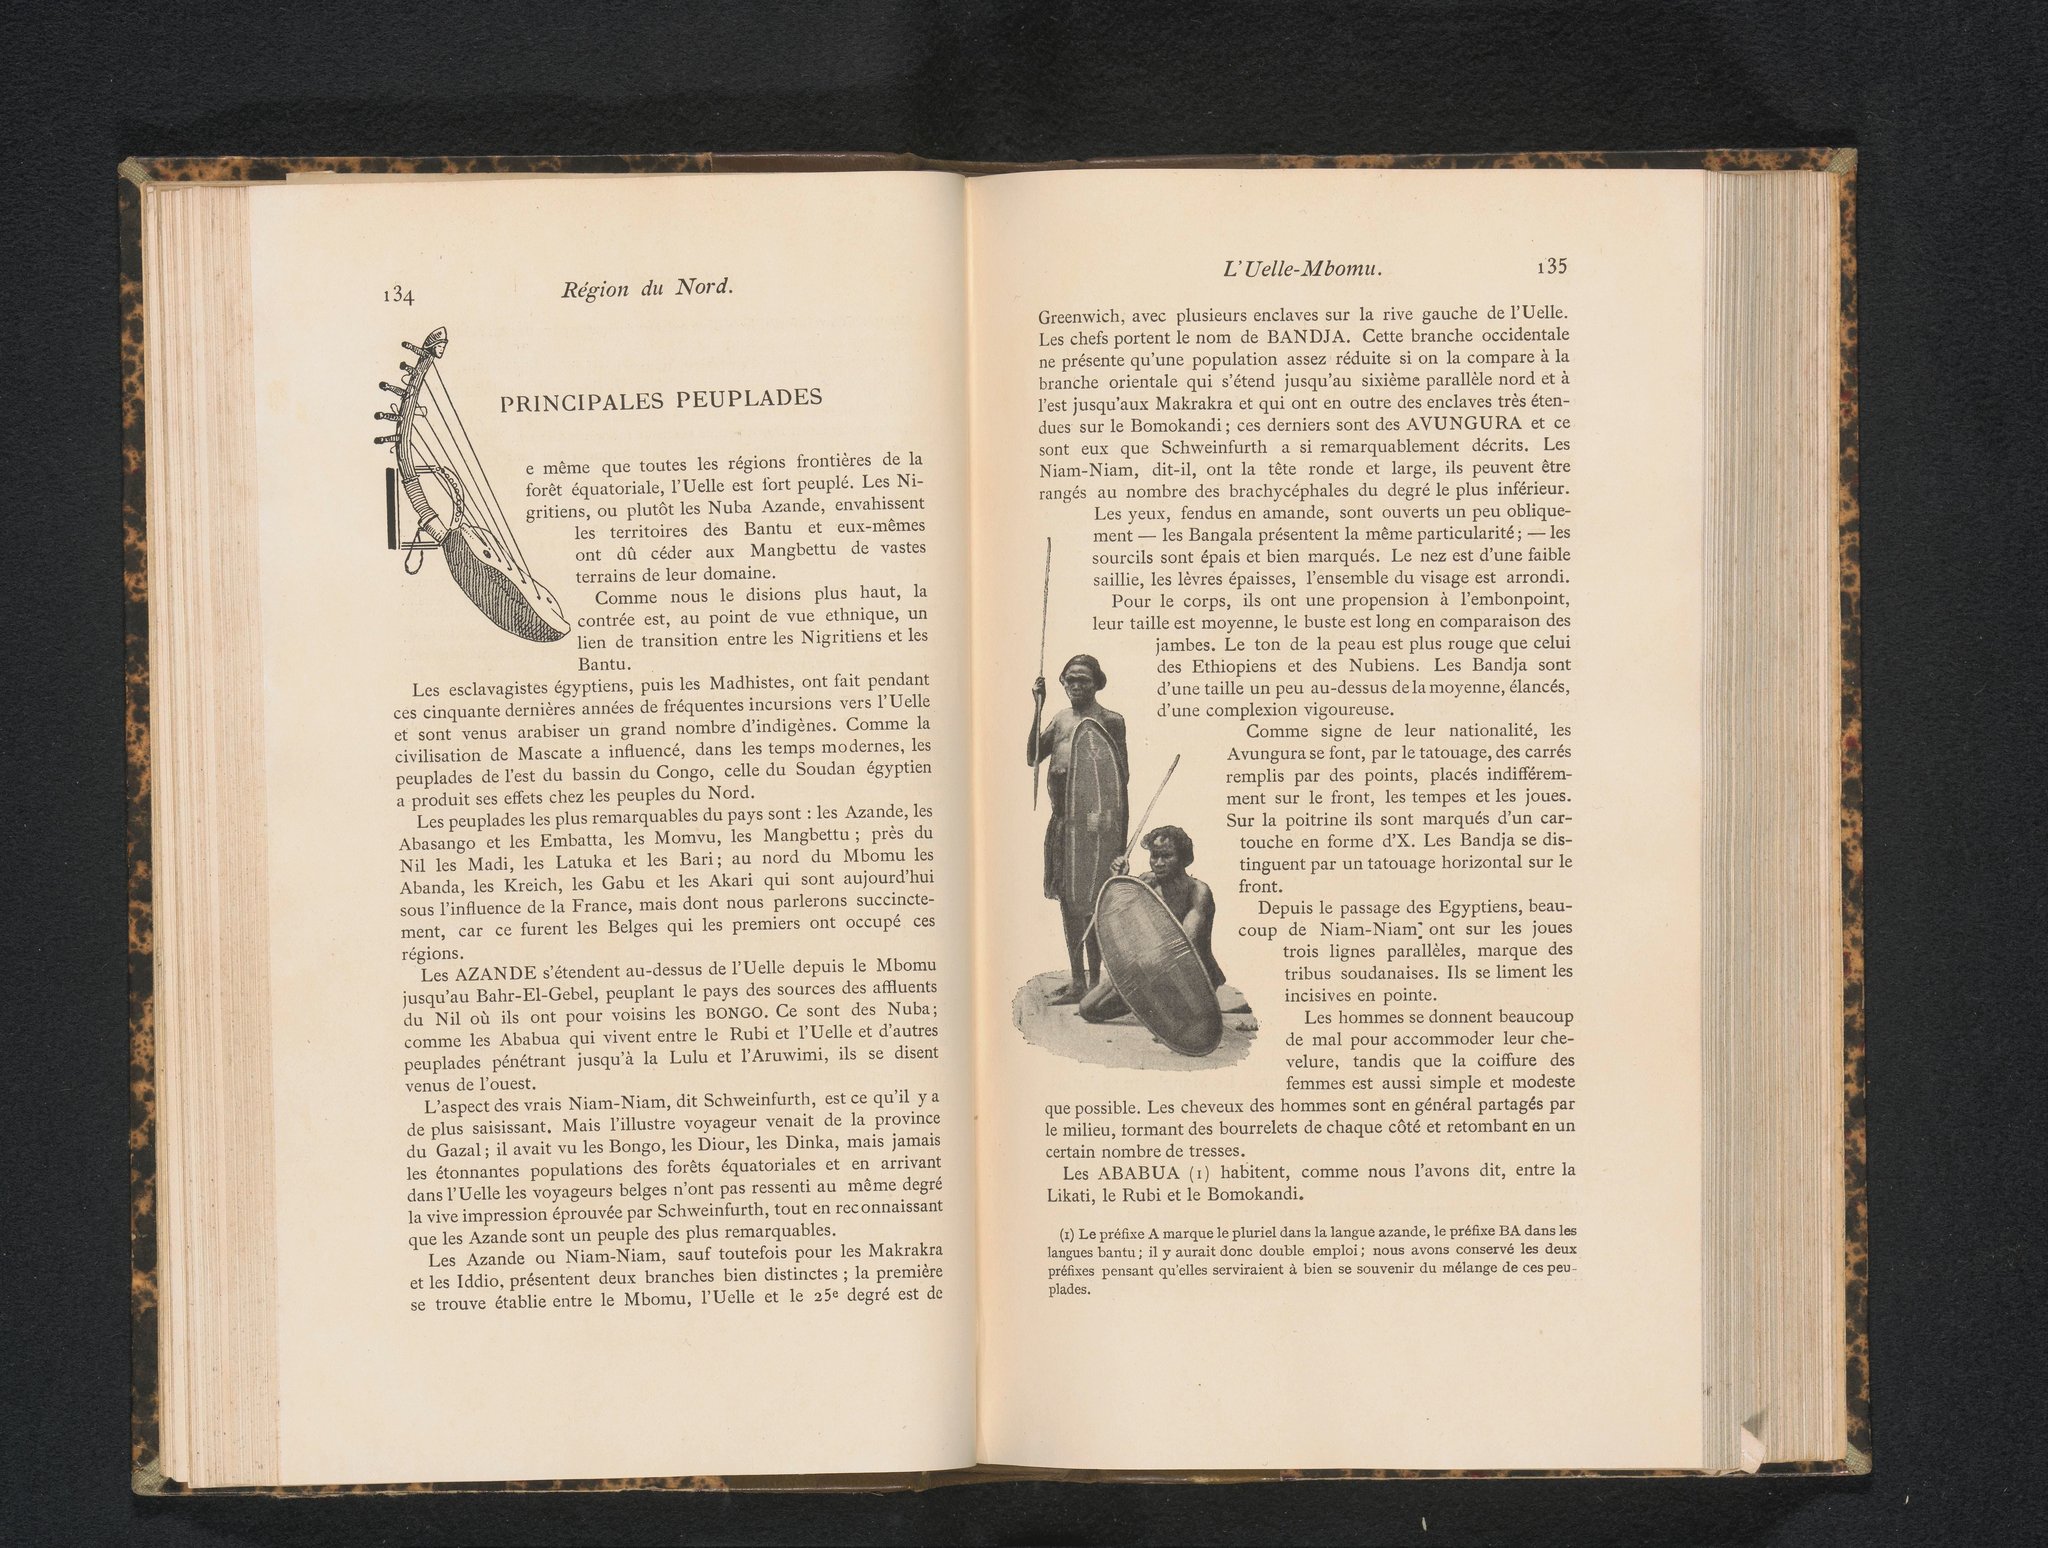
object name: page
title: Portret van twee onbekende personen gewapend met speer en schild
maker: Anonymous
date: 1887-1892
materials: paper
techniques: autotype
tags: protective weapons: shield, historical persons, casting weapons: spear